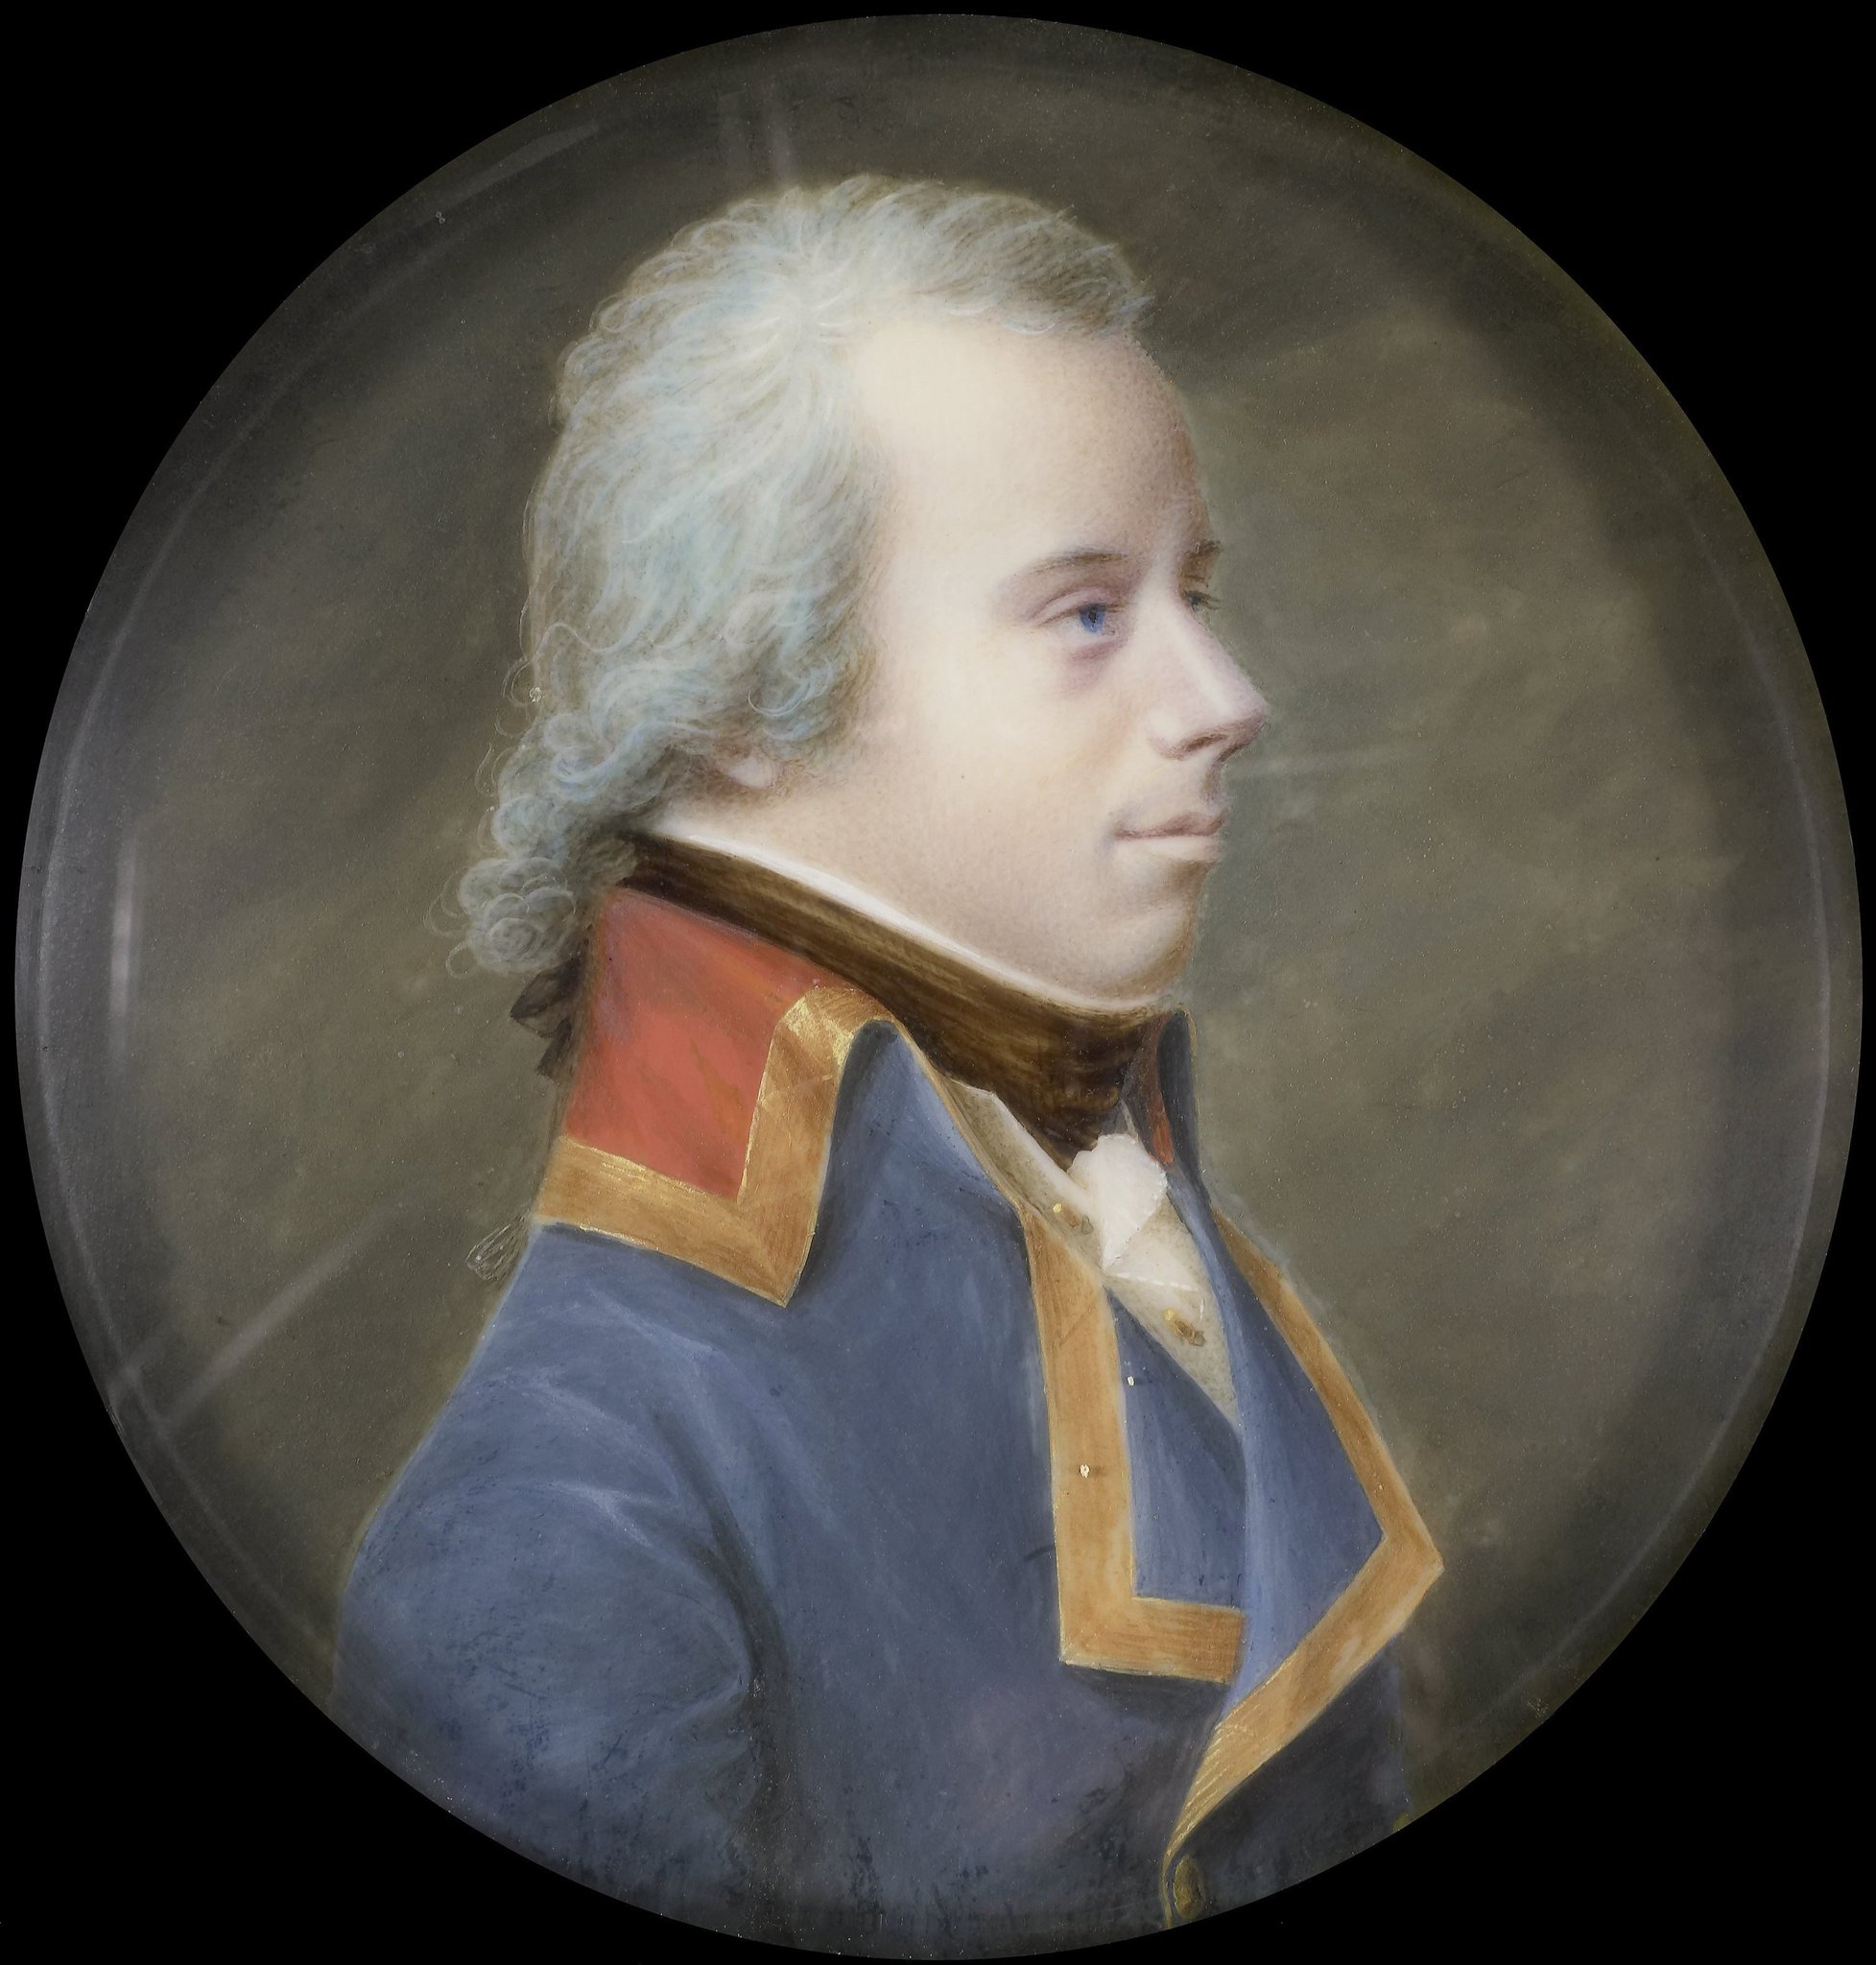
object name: painting, miniature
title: Willem George Frederik (1774-99), prins van Oranje-Nassau. Jongste zoon van prins Willem V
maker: Anonymous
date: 1795-1810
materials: glass, ivory, metal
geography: germany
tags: willem george frederik (prins van oranje-nassau), prince, historical persons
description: Willem George Frederik (1774 - 99), Prince of Orange-Nassau, youngest son of Prince Willem V. German school, c. 1800. ivory.